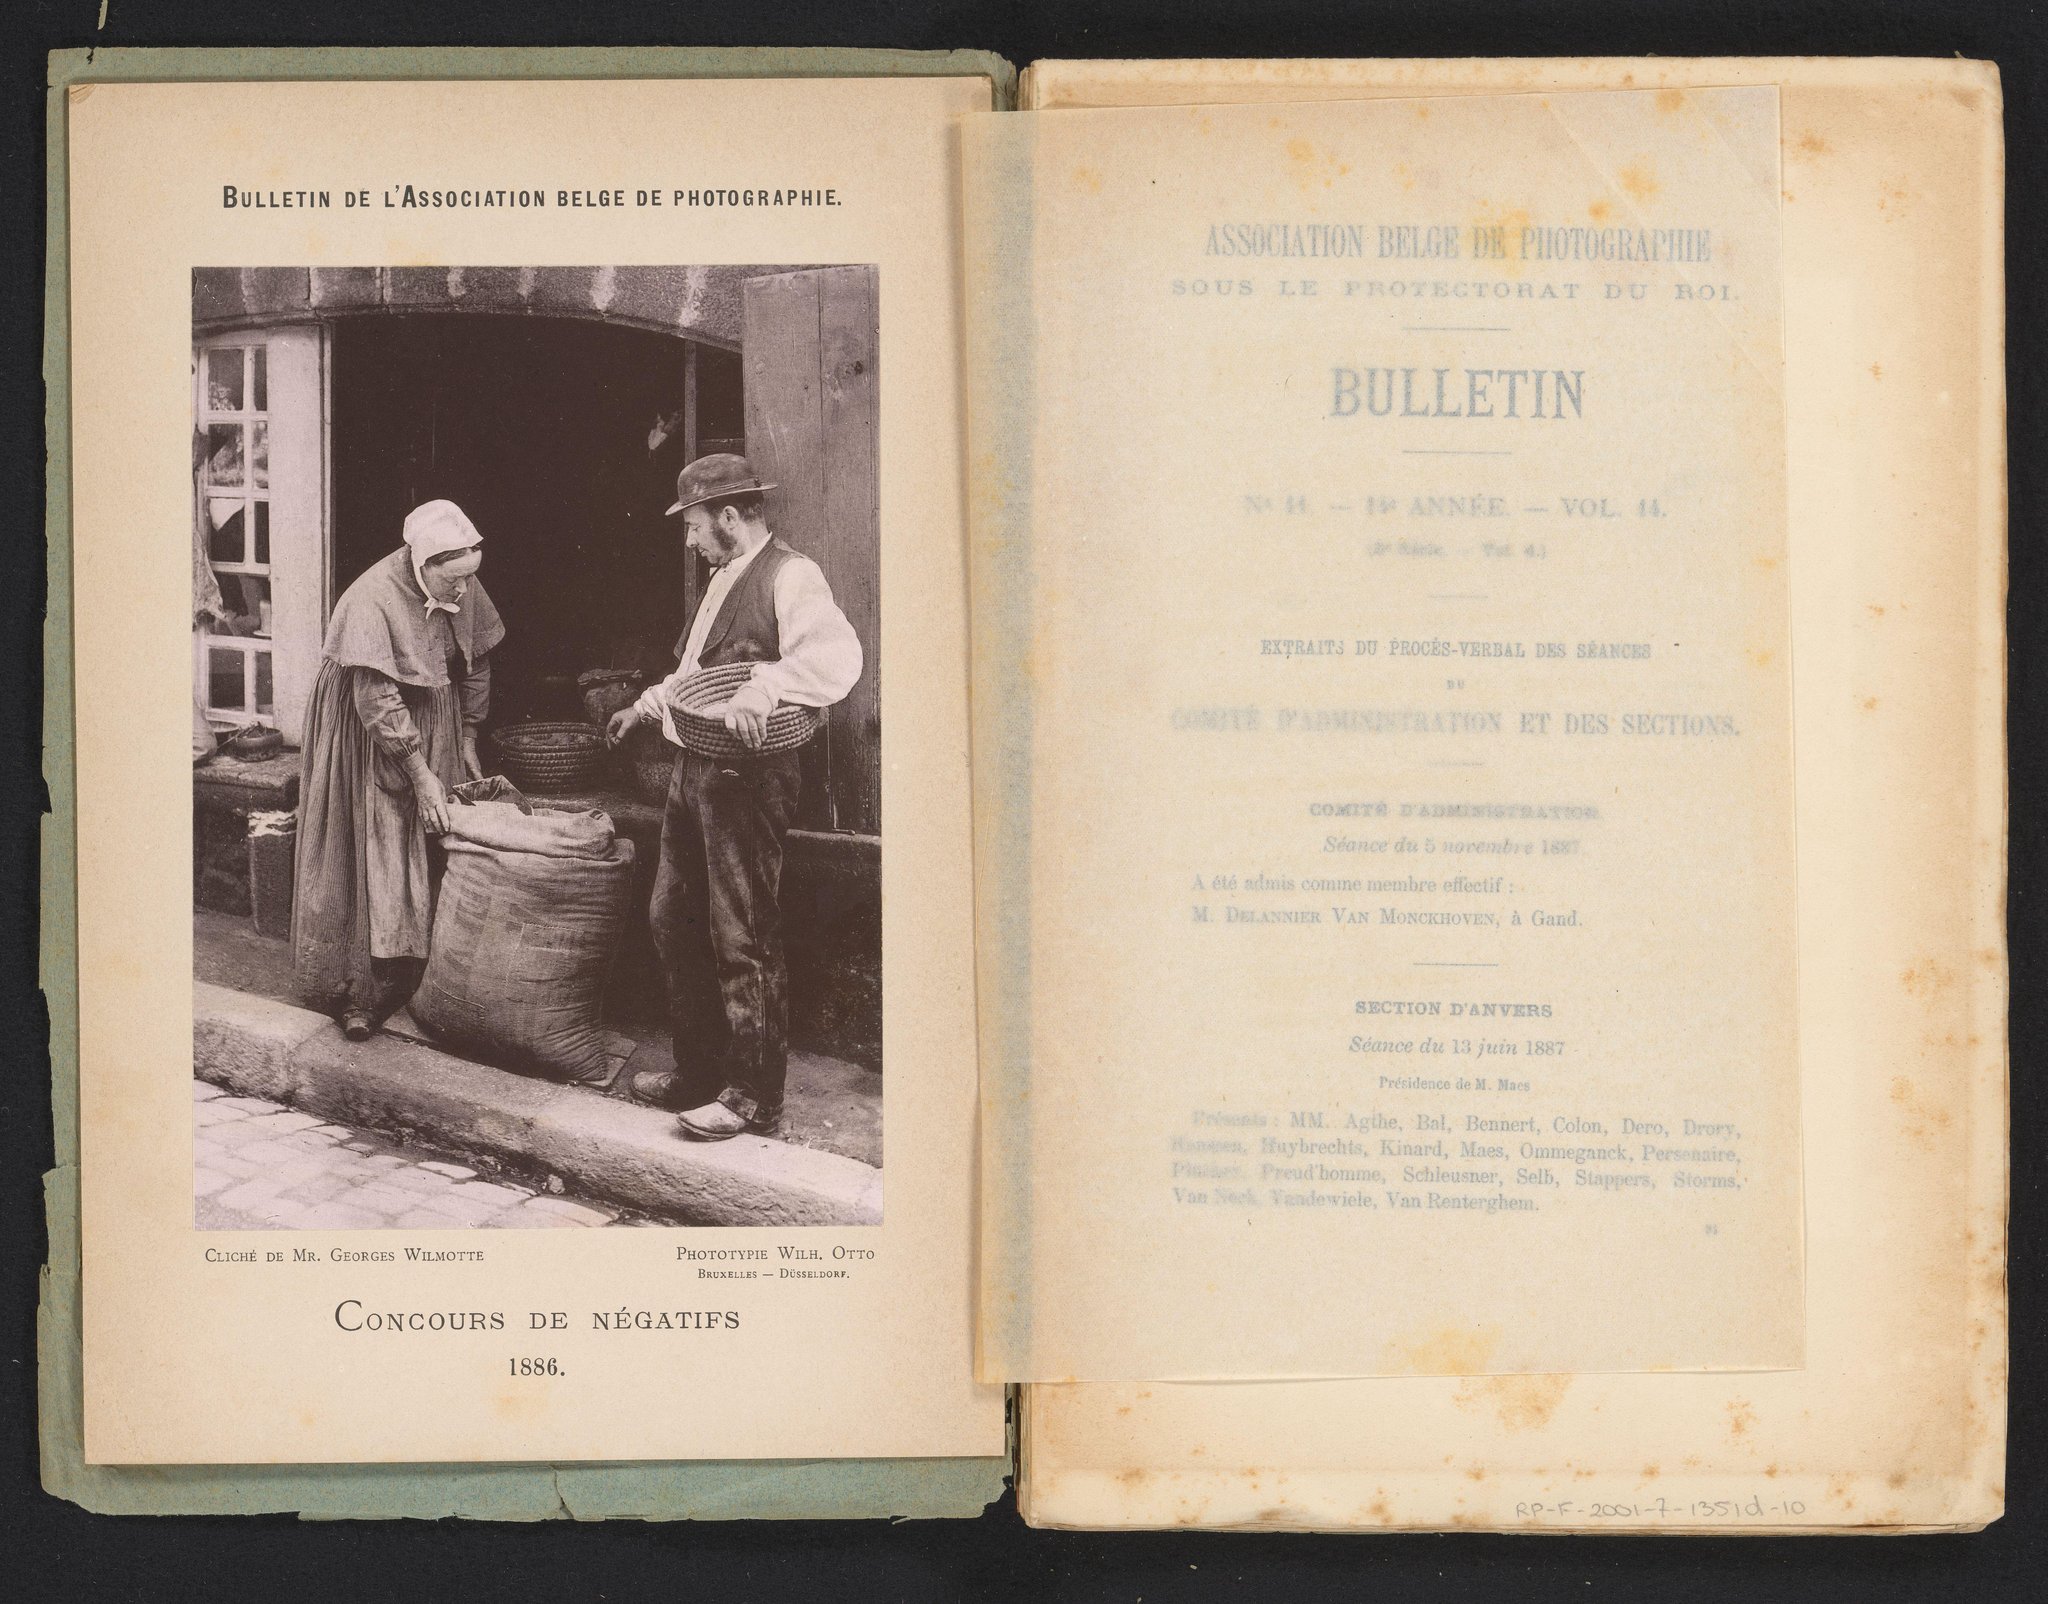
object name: photomechanical print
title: Man en een vrouw met een zak etenswaren op straat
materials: paper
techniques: photograph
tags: adult woman, adult man, container of textile material: bag, sack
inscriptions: inscription: ‘Concours de negatifs/ 1886.’, inscription: ‘Bulletin de l'Association belge de photographie’